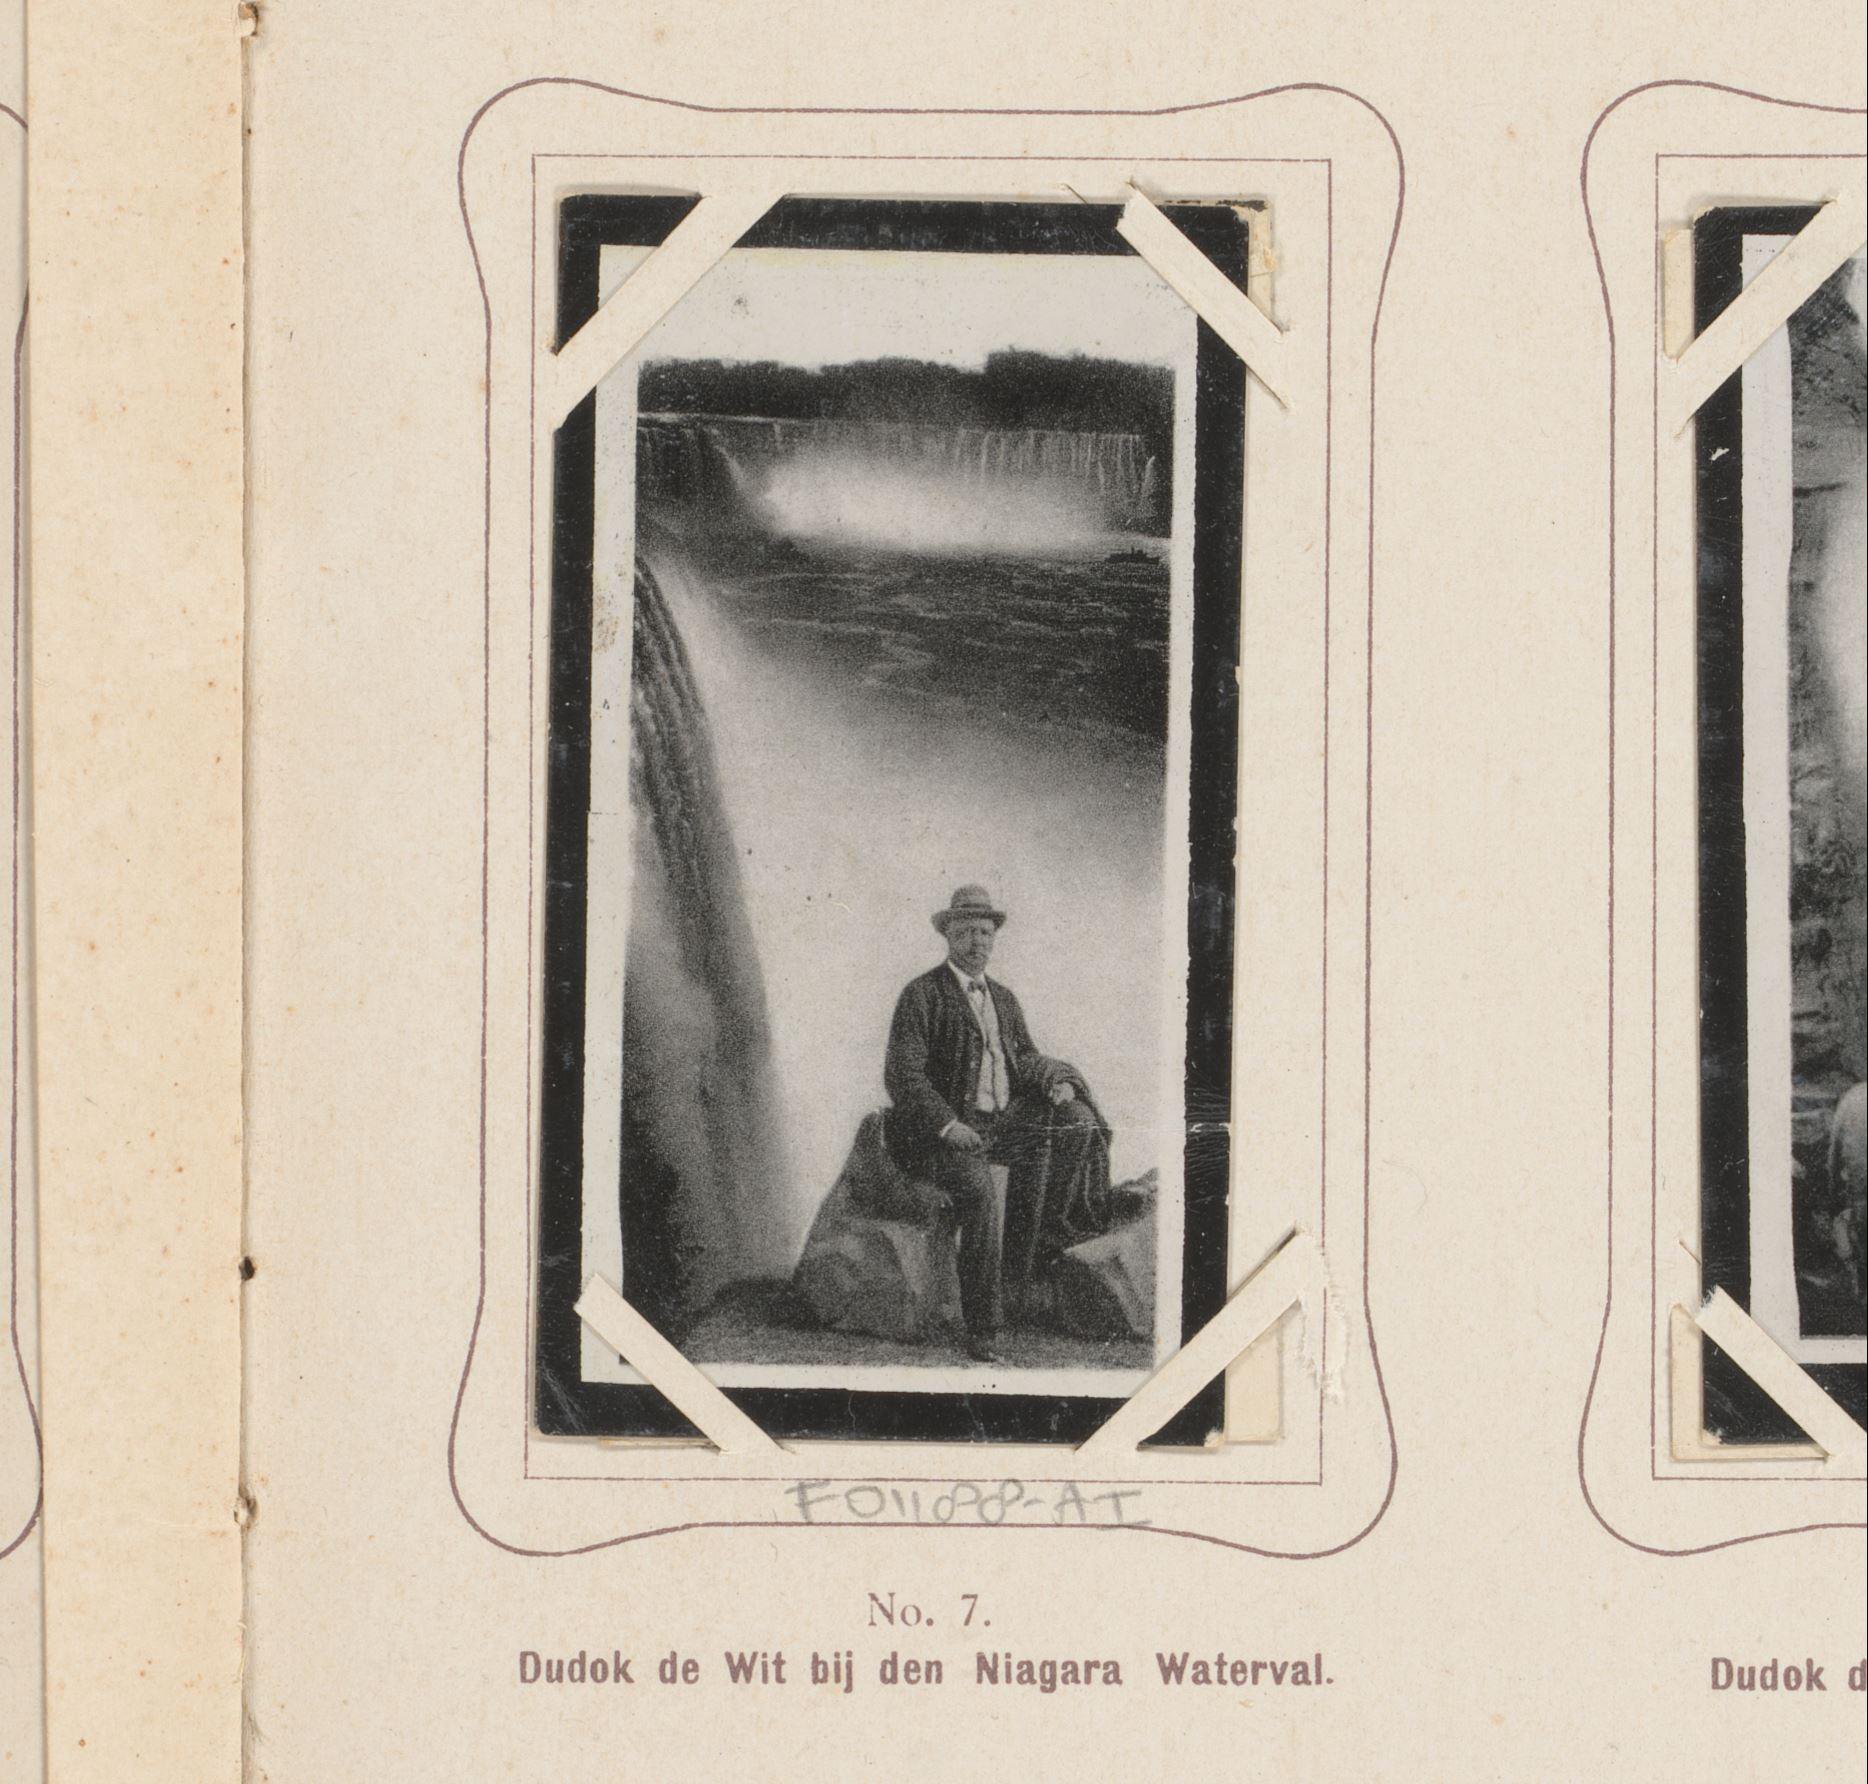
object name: photomechanical print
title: Portret van de heer Dudok de Wit bij de Niagara watervallen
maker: Anonymous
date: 1906-1907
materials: paper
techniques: photograph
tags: waterfall, historical persons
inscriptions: inscription: ‘No. 7./ Dudok de Wit bij den Niagara Waterval.’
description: Deze prent maakt deel uit van een album.